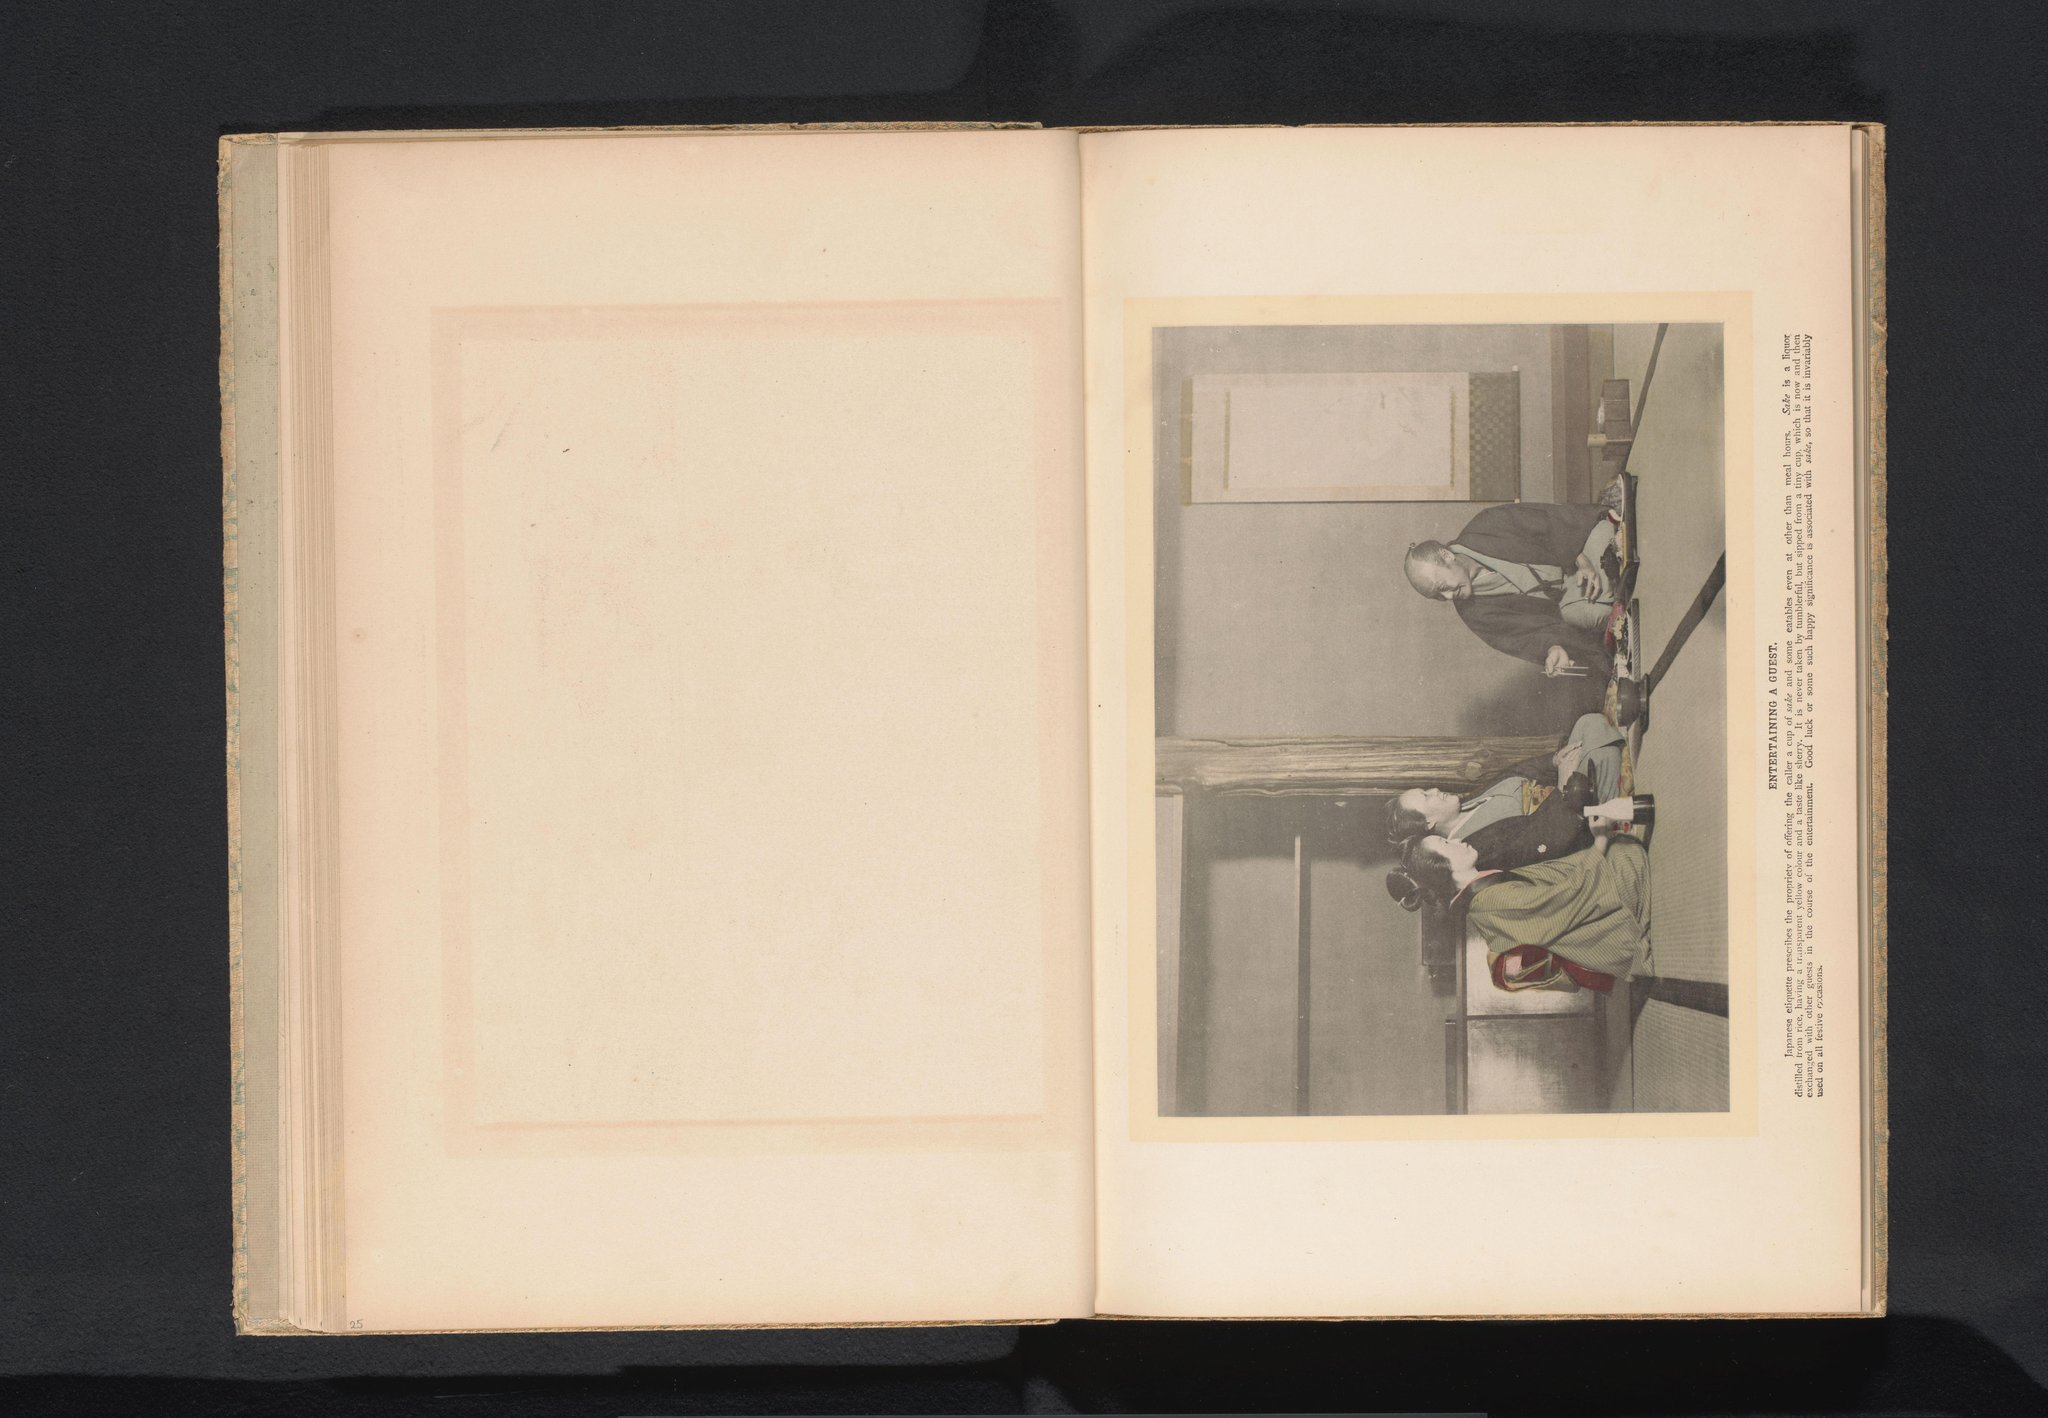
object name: photomechanical print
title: Twee vrouwen en een man eten samen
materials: paper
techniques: photograph, lithograph, hand coloring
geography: tokyo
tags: visiting; receiving guests; elegant company, eating, japan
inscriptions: inscription: ‘Japanese etiquette (...) festive occasions.’